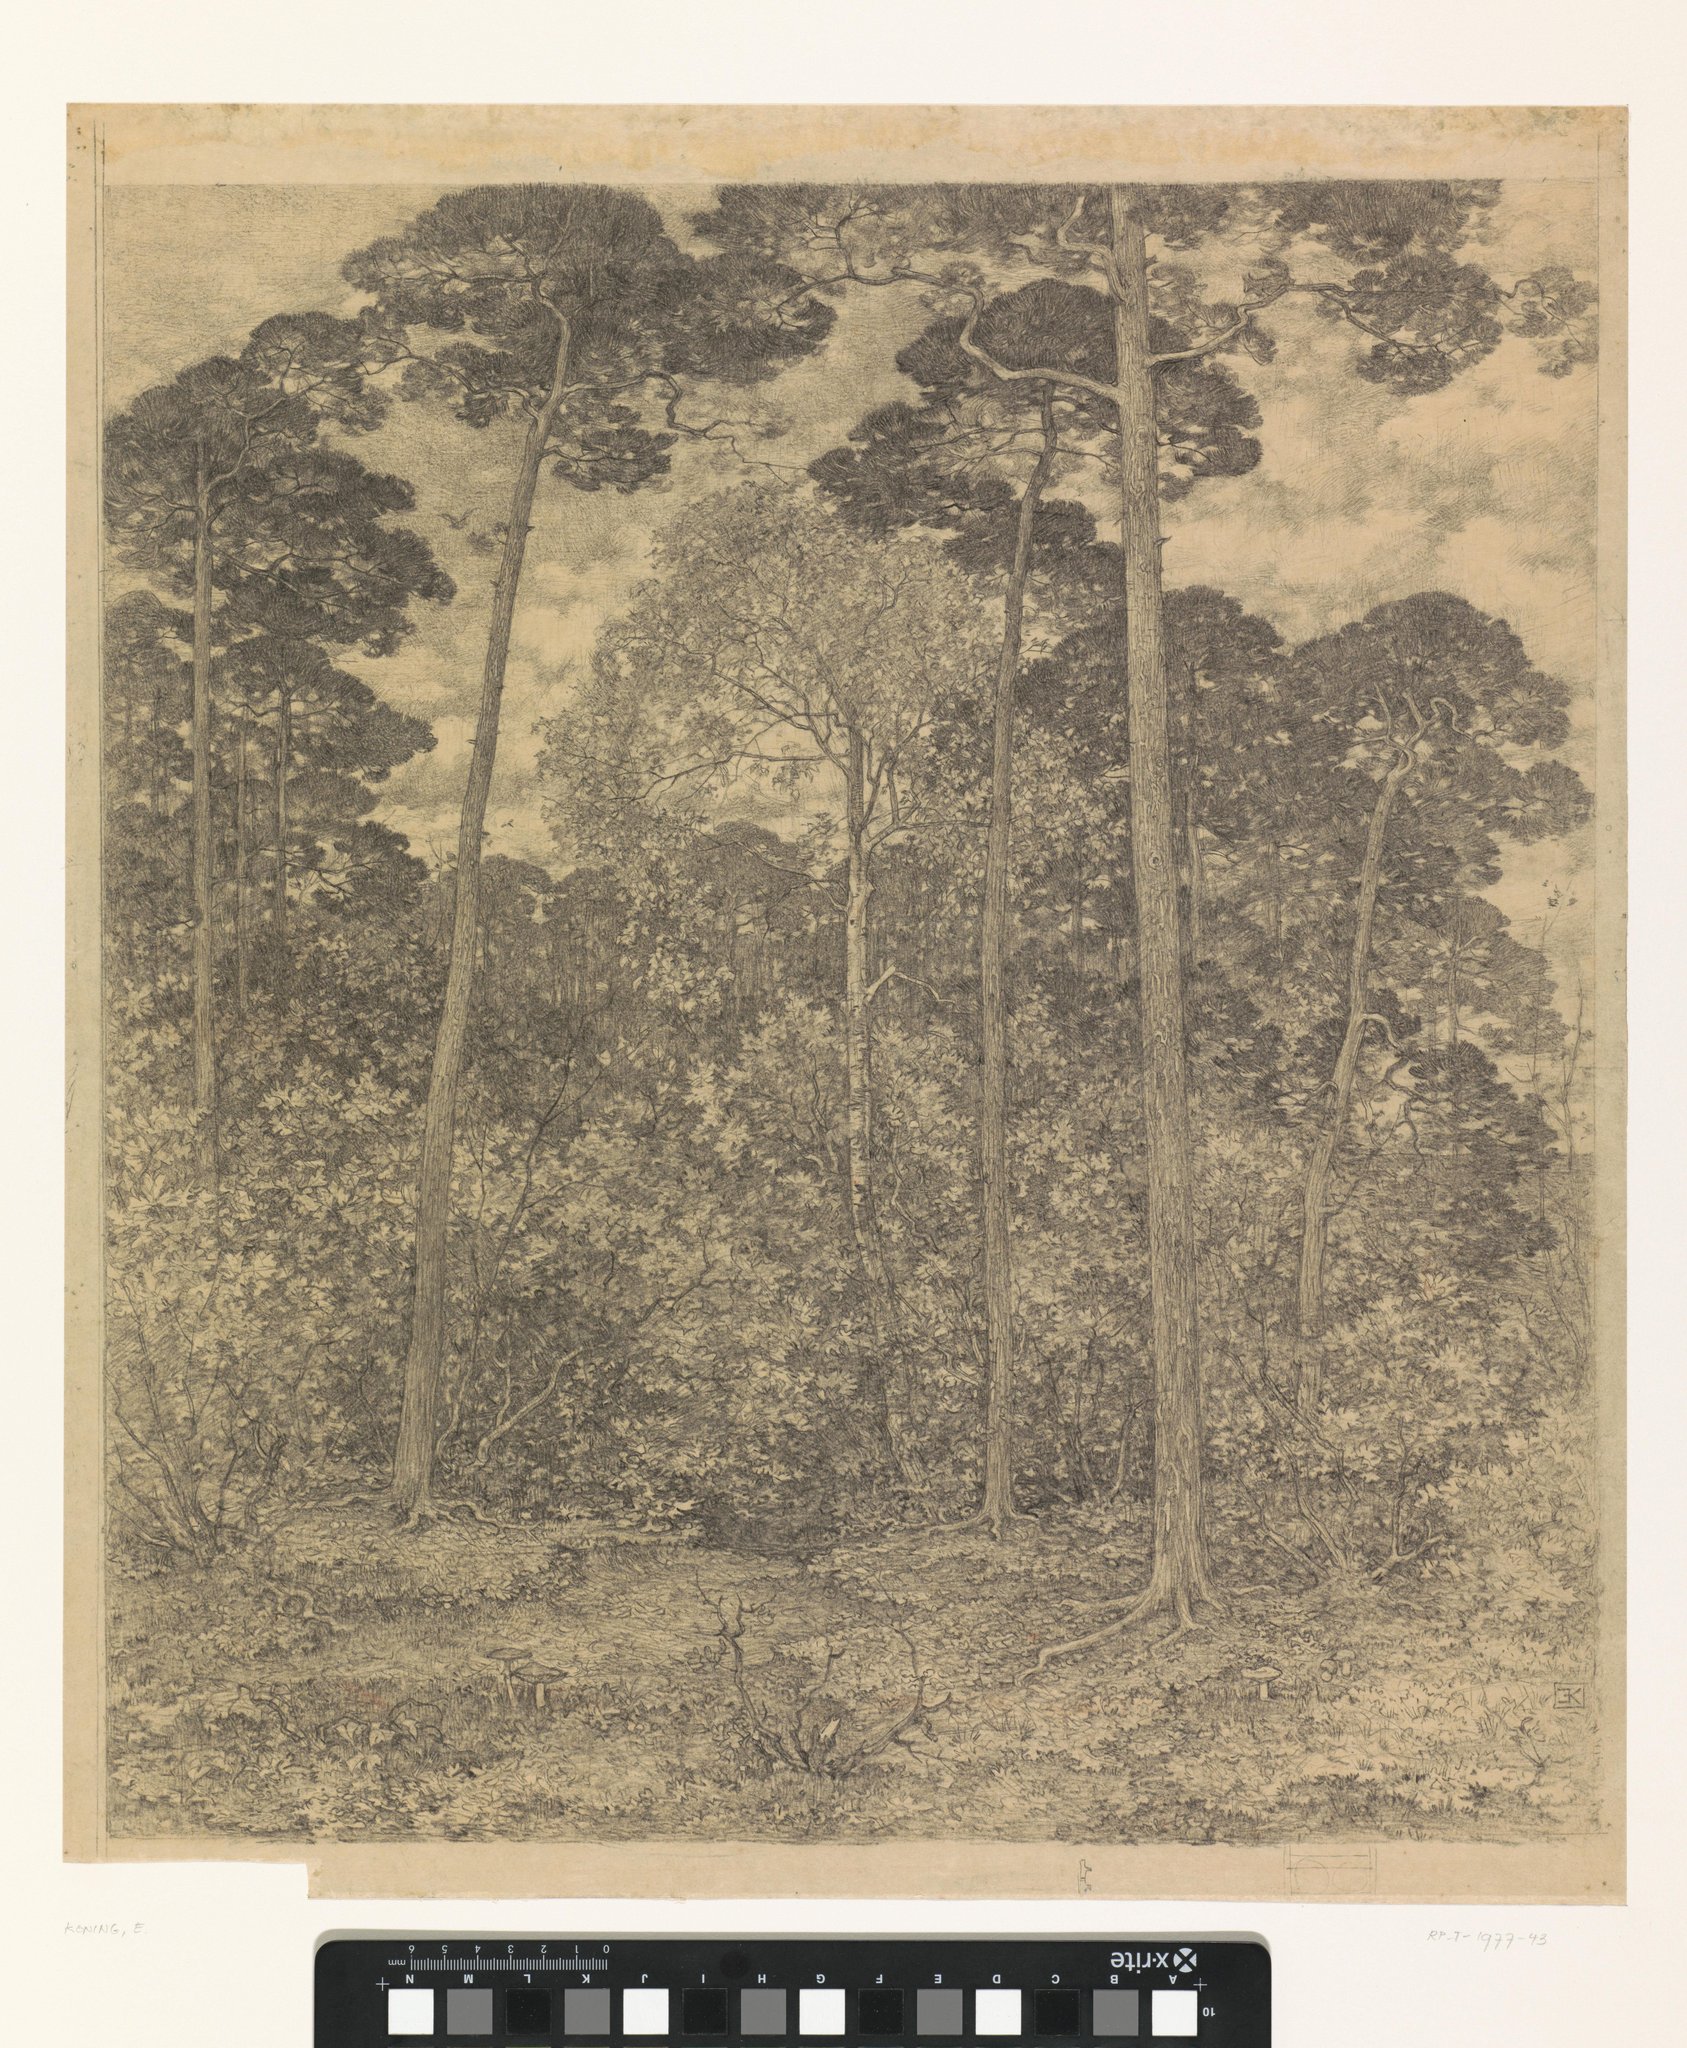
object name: drawing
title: Bosgezicht bij Scherpenzeel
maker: edzard koning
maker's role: draughtsman, print maker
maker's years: 1869-1954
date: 1879-1954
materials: chalk, paper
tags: forest, wood